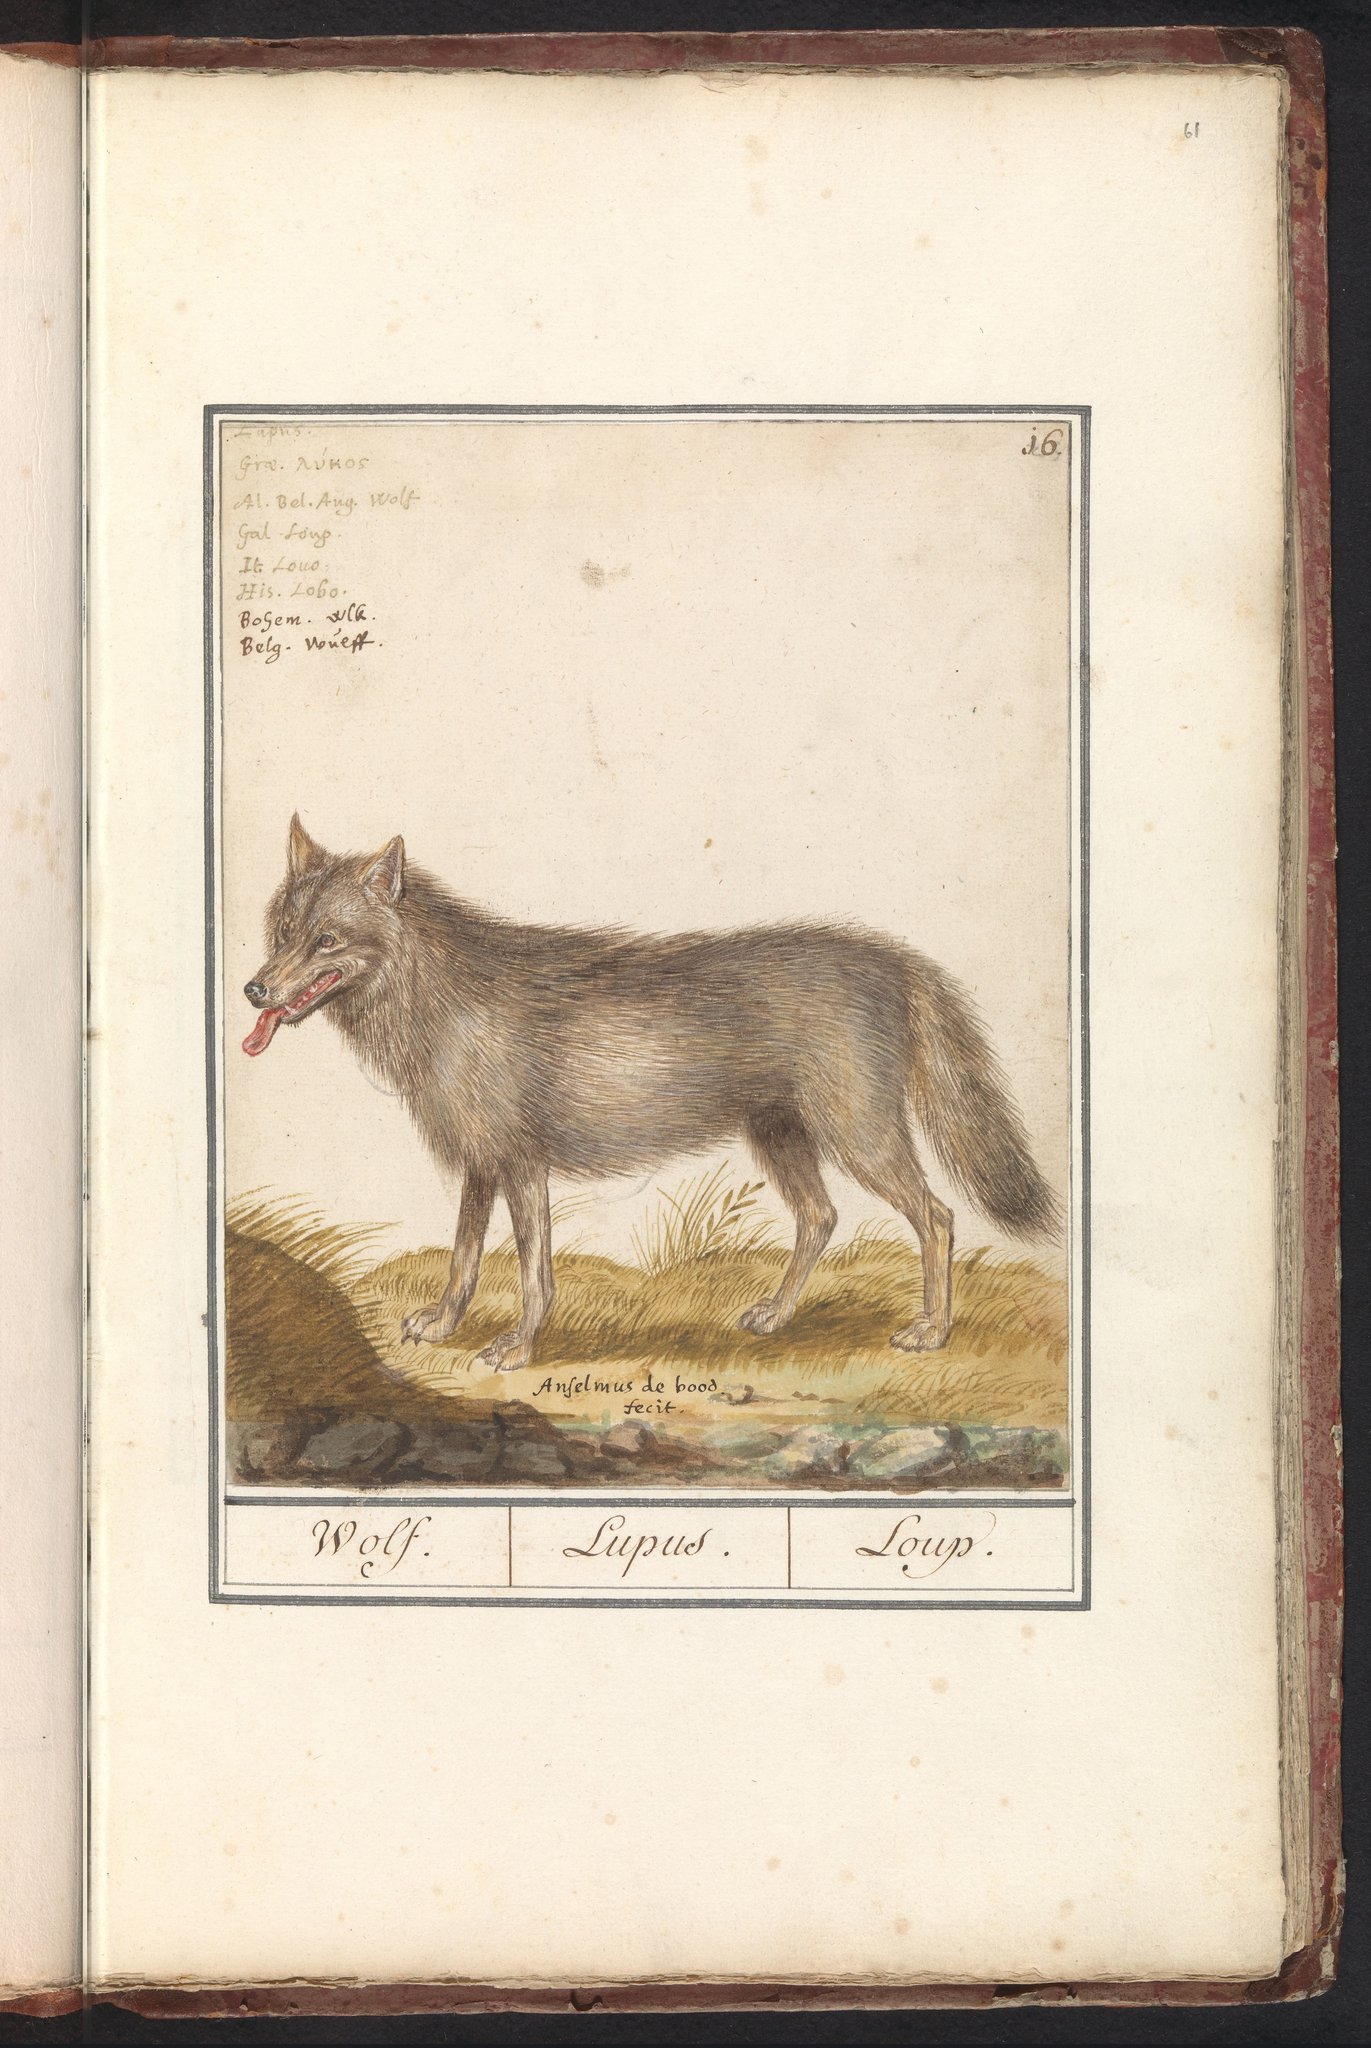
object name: drawing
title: Wolf (Canis lupus)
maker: anselmus boëtius de boodt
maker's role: draughtsman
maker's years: 1550-1632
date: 1596-1610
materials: paint, ink, paper, watercolor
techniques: brush, pen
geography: prague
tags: beasts of prey, predatory animals: wolf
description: Wolf. Rechtsboven genummerd: 16. Linksboven de naam in acht talen. Onderdeel van het eerste album met tekeningen van viervoeters. Eerste van twaalf albums met tekeningen van dieren, vogels en planten bekend rond 1600, gemaakt in opdracht van keizer Rudolf II. Met toelichting in Nederlands, Latijn en Frans.